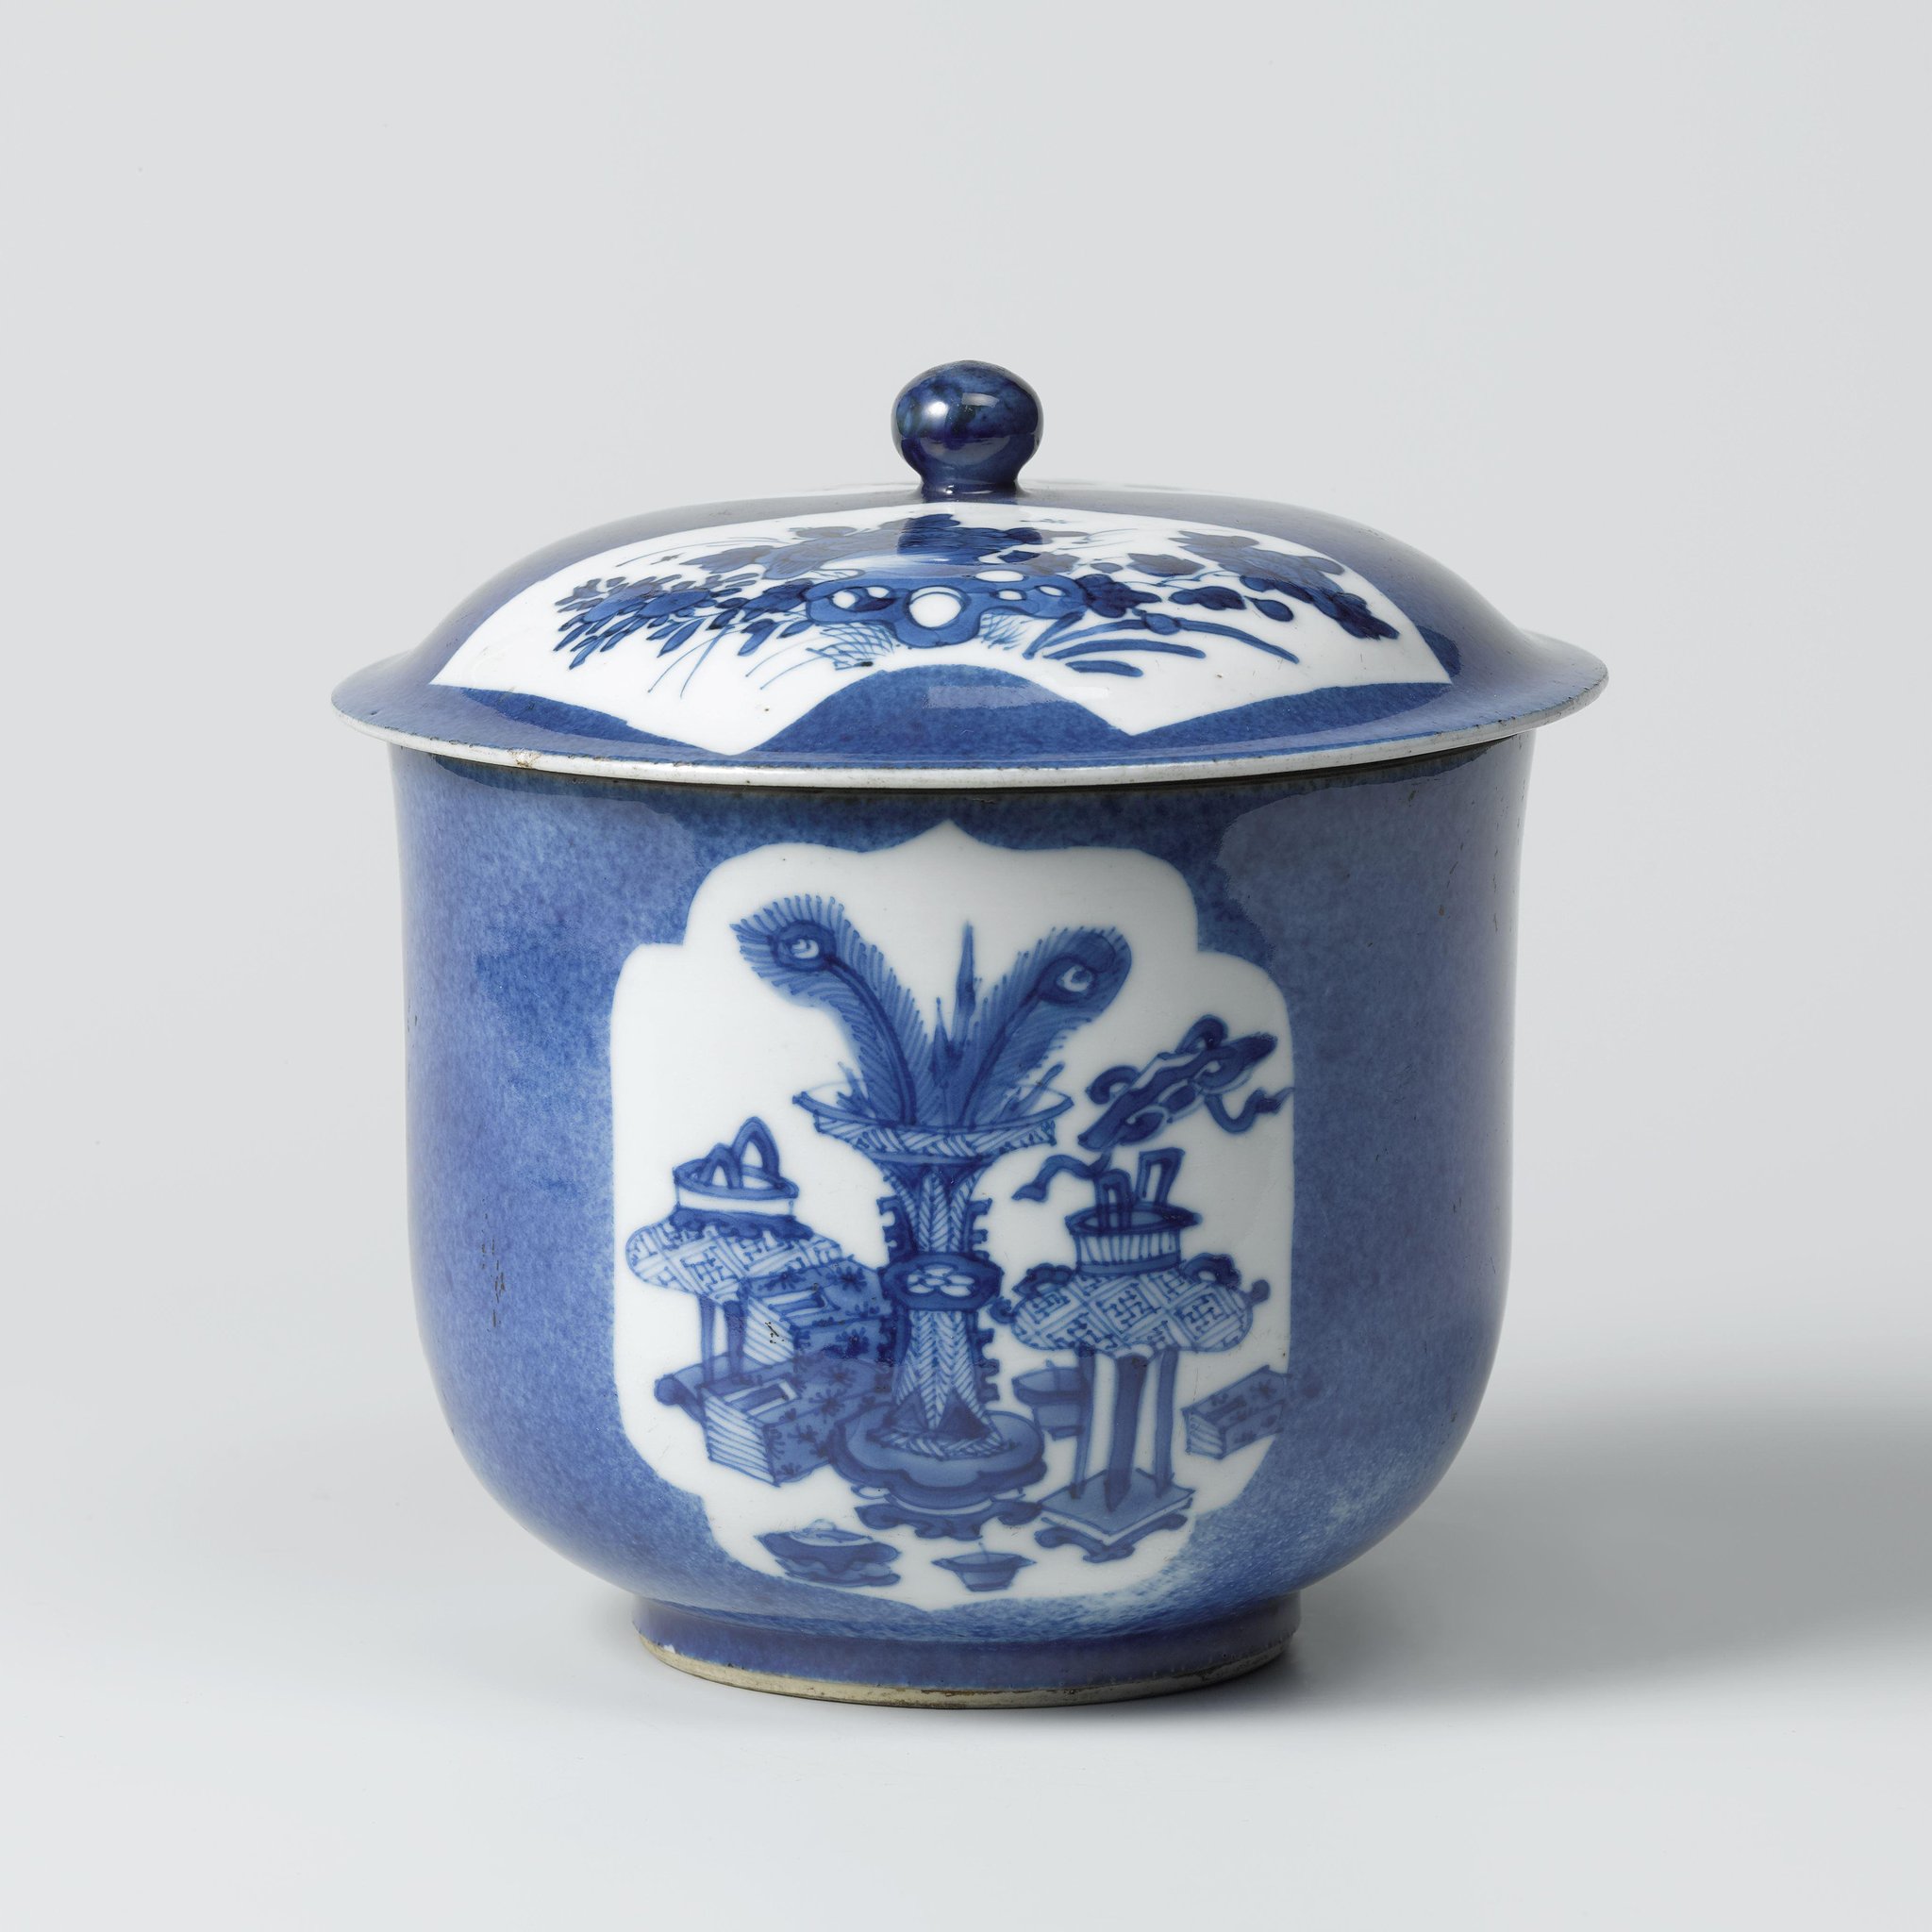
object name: covered jar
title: Covered jar with antiquities and flowering plants near a rock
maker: Anonymous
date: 1700-1720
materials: cobalt, glaze, paint, porcelain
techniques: firing, turning, vitrification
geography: china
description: A long and bloody civil war halted exports of Chinese porcelain in the mid-17th century. Peace was restored only several decades later, in the 1680s, by the first Kangxi emperor. Unprecedented amounts of blue-and-white and polychrome porcelain then began to be exported to Europe. The blue around the painted scenes on this lidded jar was applied in powder form: such ware is called ‘powder blue’ porcelain.